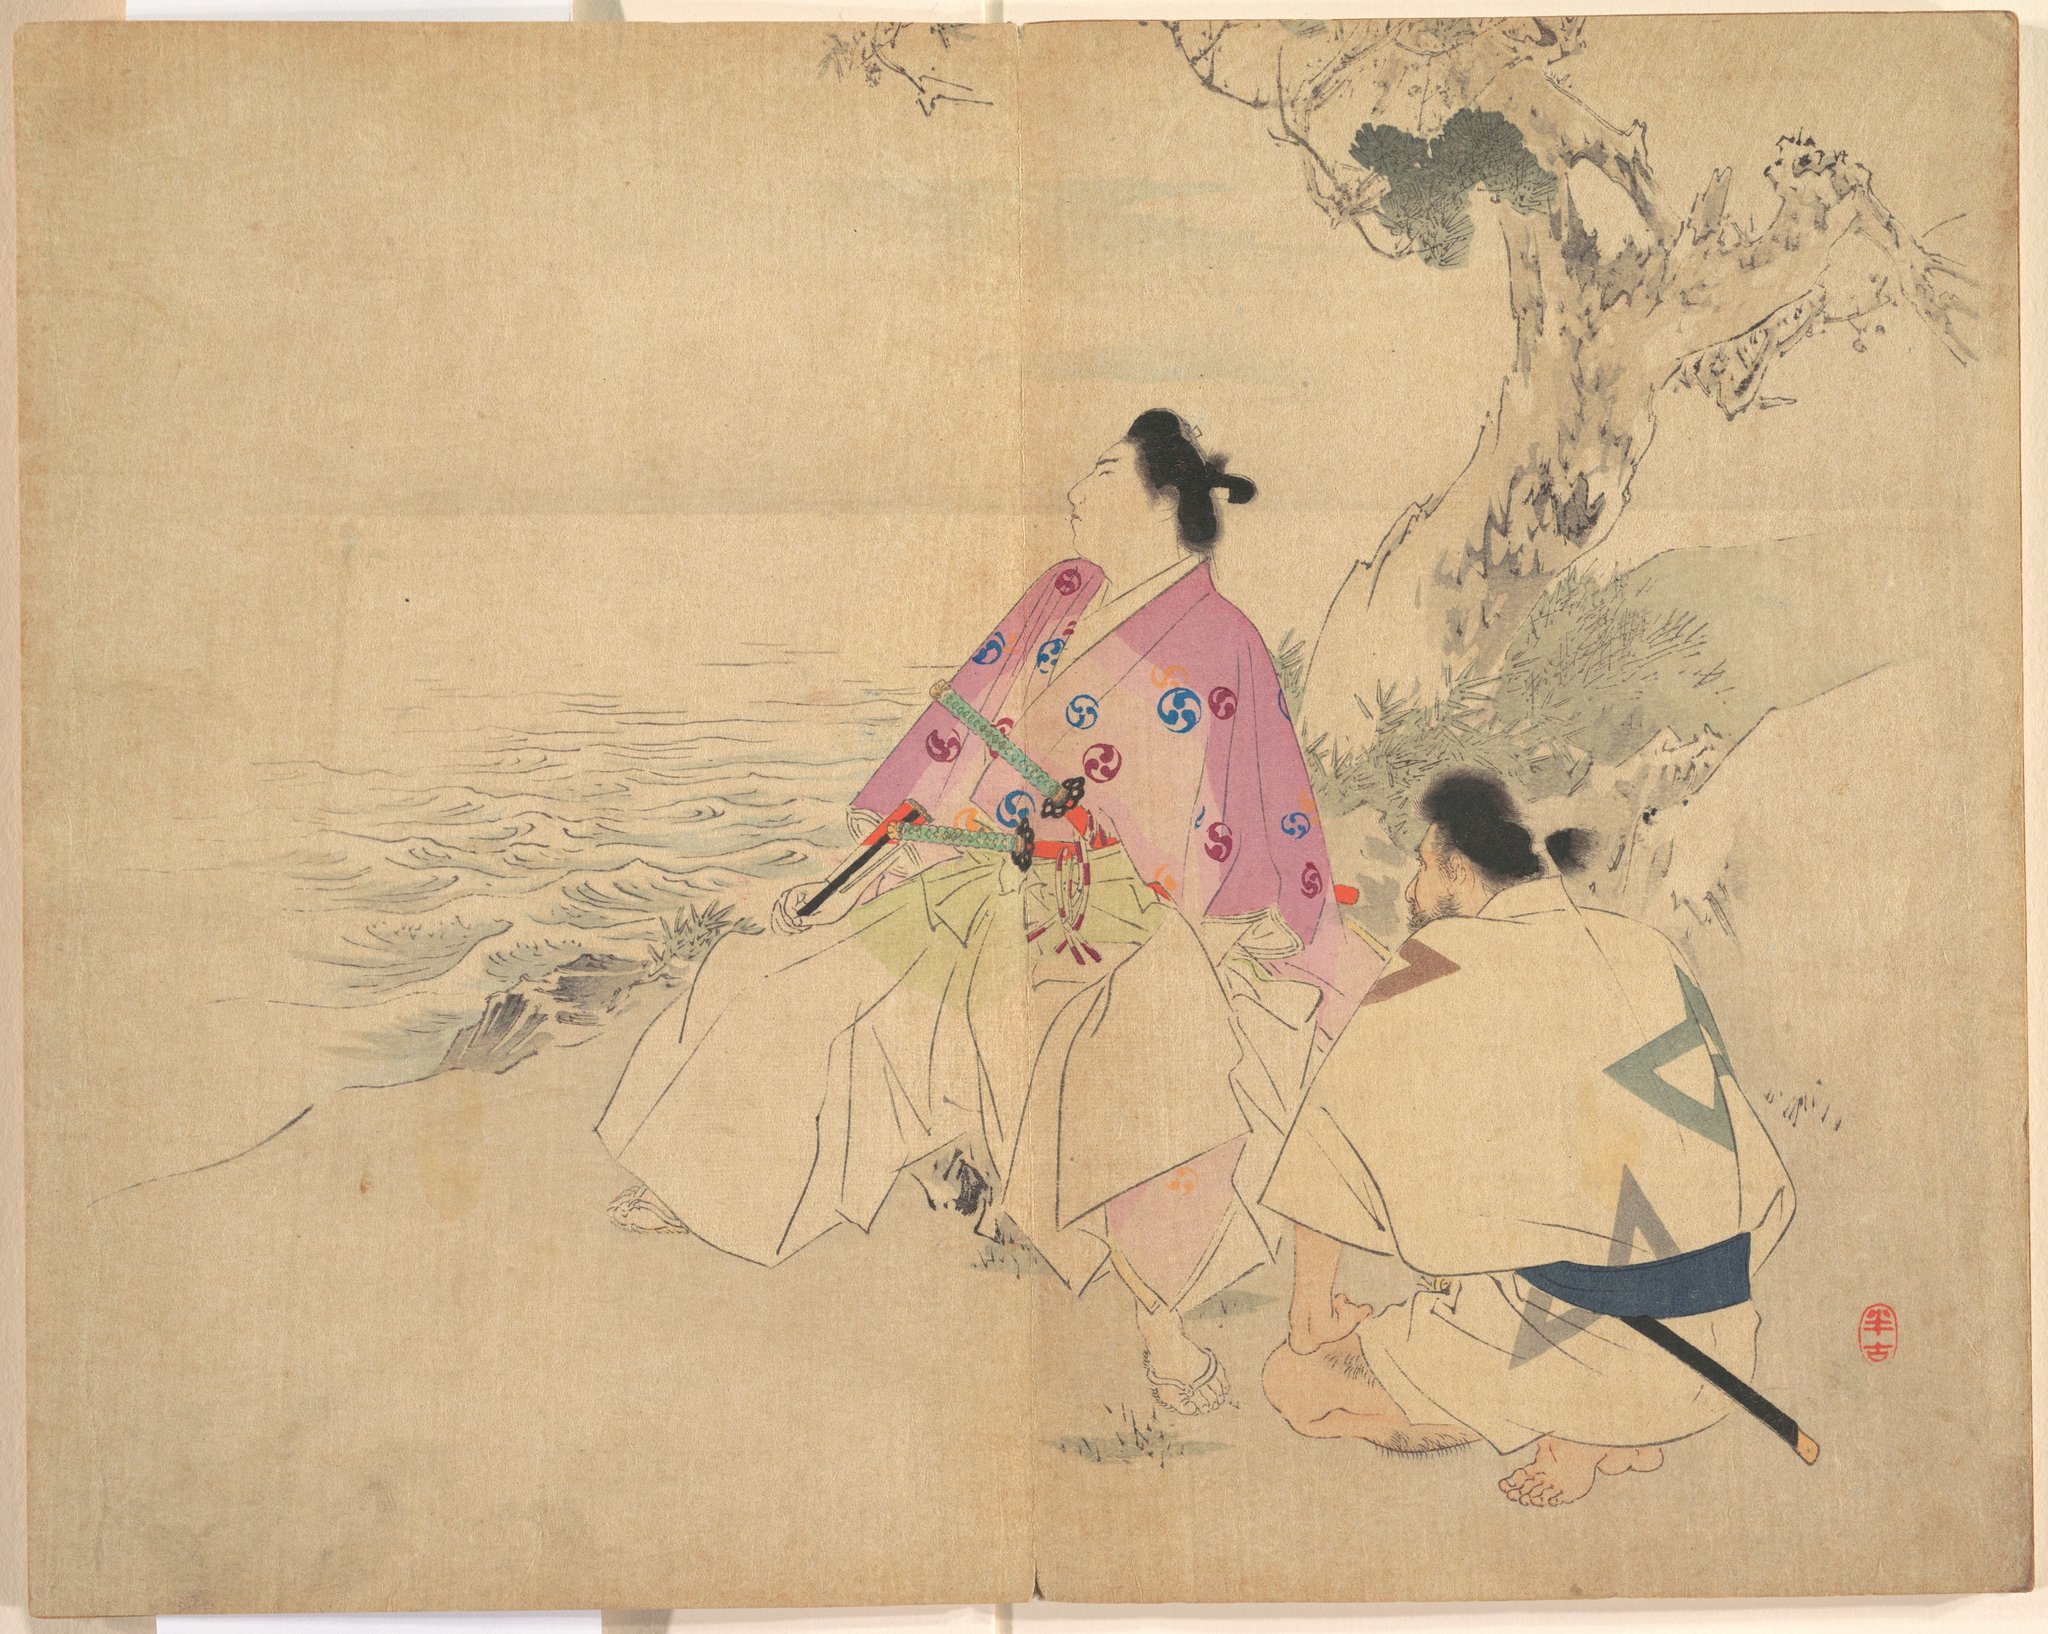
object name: print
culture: japanese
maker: kajita hanko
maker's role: artist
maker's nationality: japanese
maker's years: 1870-1917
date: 1870-1917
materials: ink, paper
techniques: woodblock print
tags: men,trees